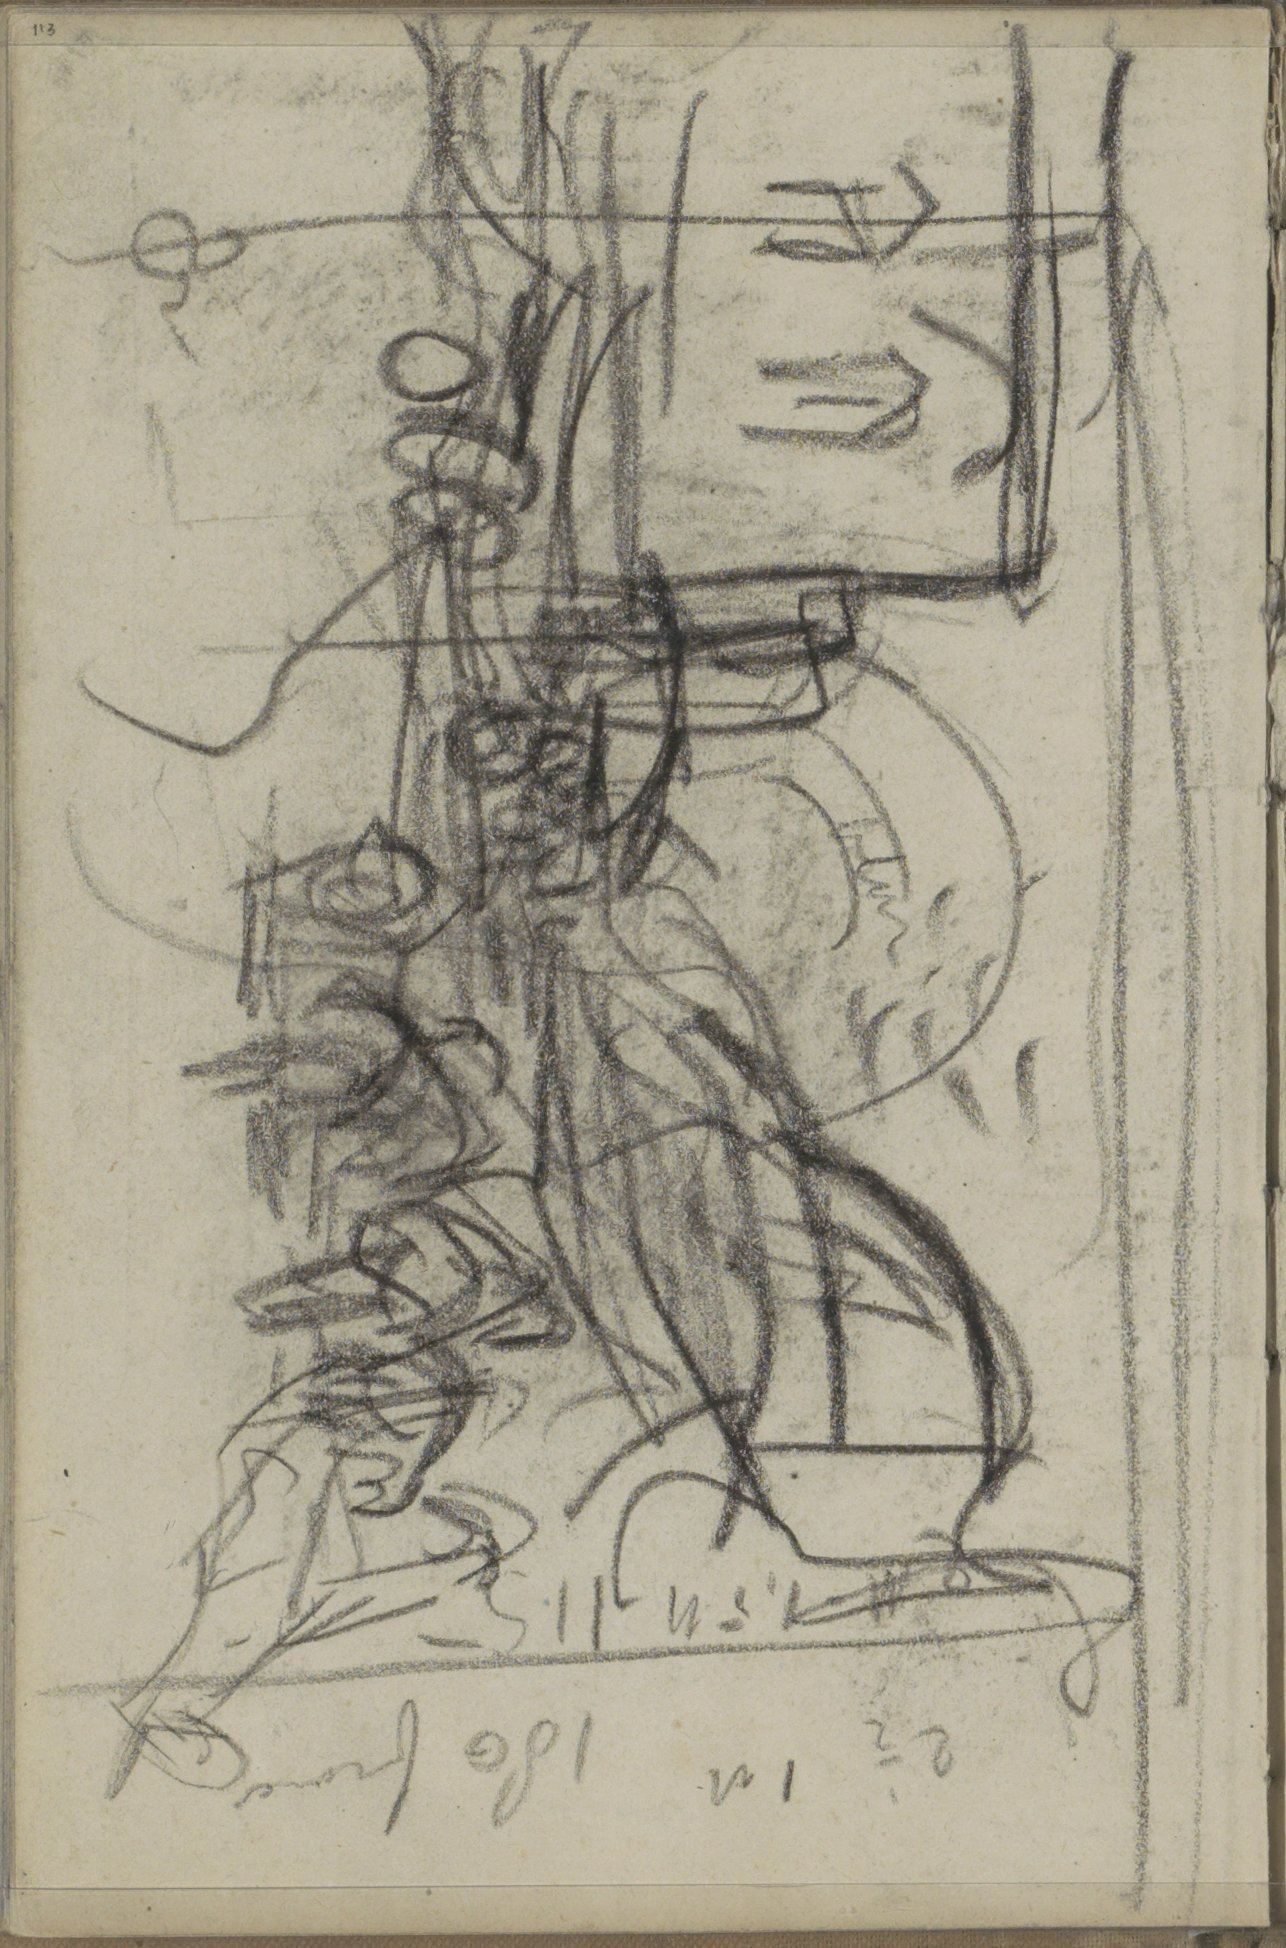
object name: sketchbook leaf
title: Paarden bij een boog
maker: marius bauer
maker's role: draughtsman, print maker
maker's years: 1867-1932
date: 1888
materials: chalk, paper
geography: istanbul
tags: arch, archivolt ~ architecture, horse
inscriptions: annotation: ‘berekening’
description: Pagina 113 uit een schetsboek met 56 bladen.